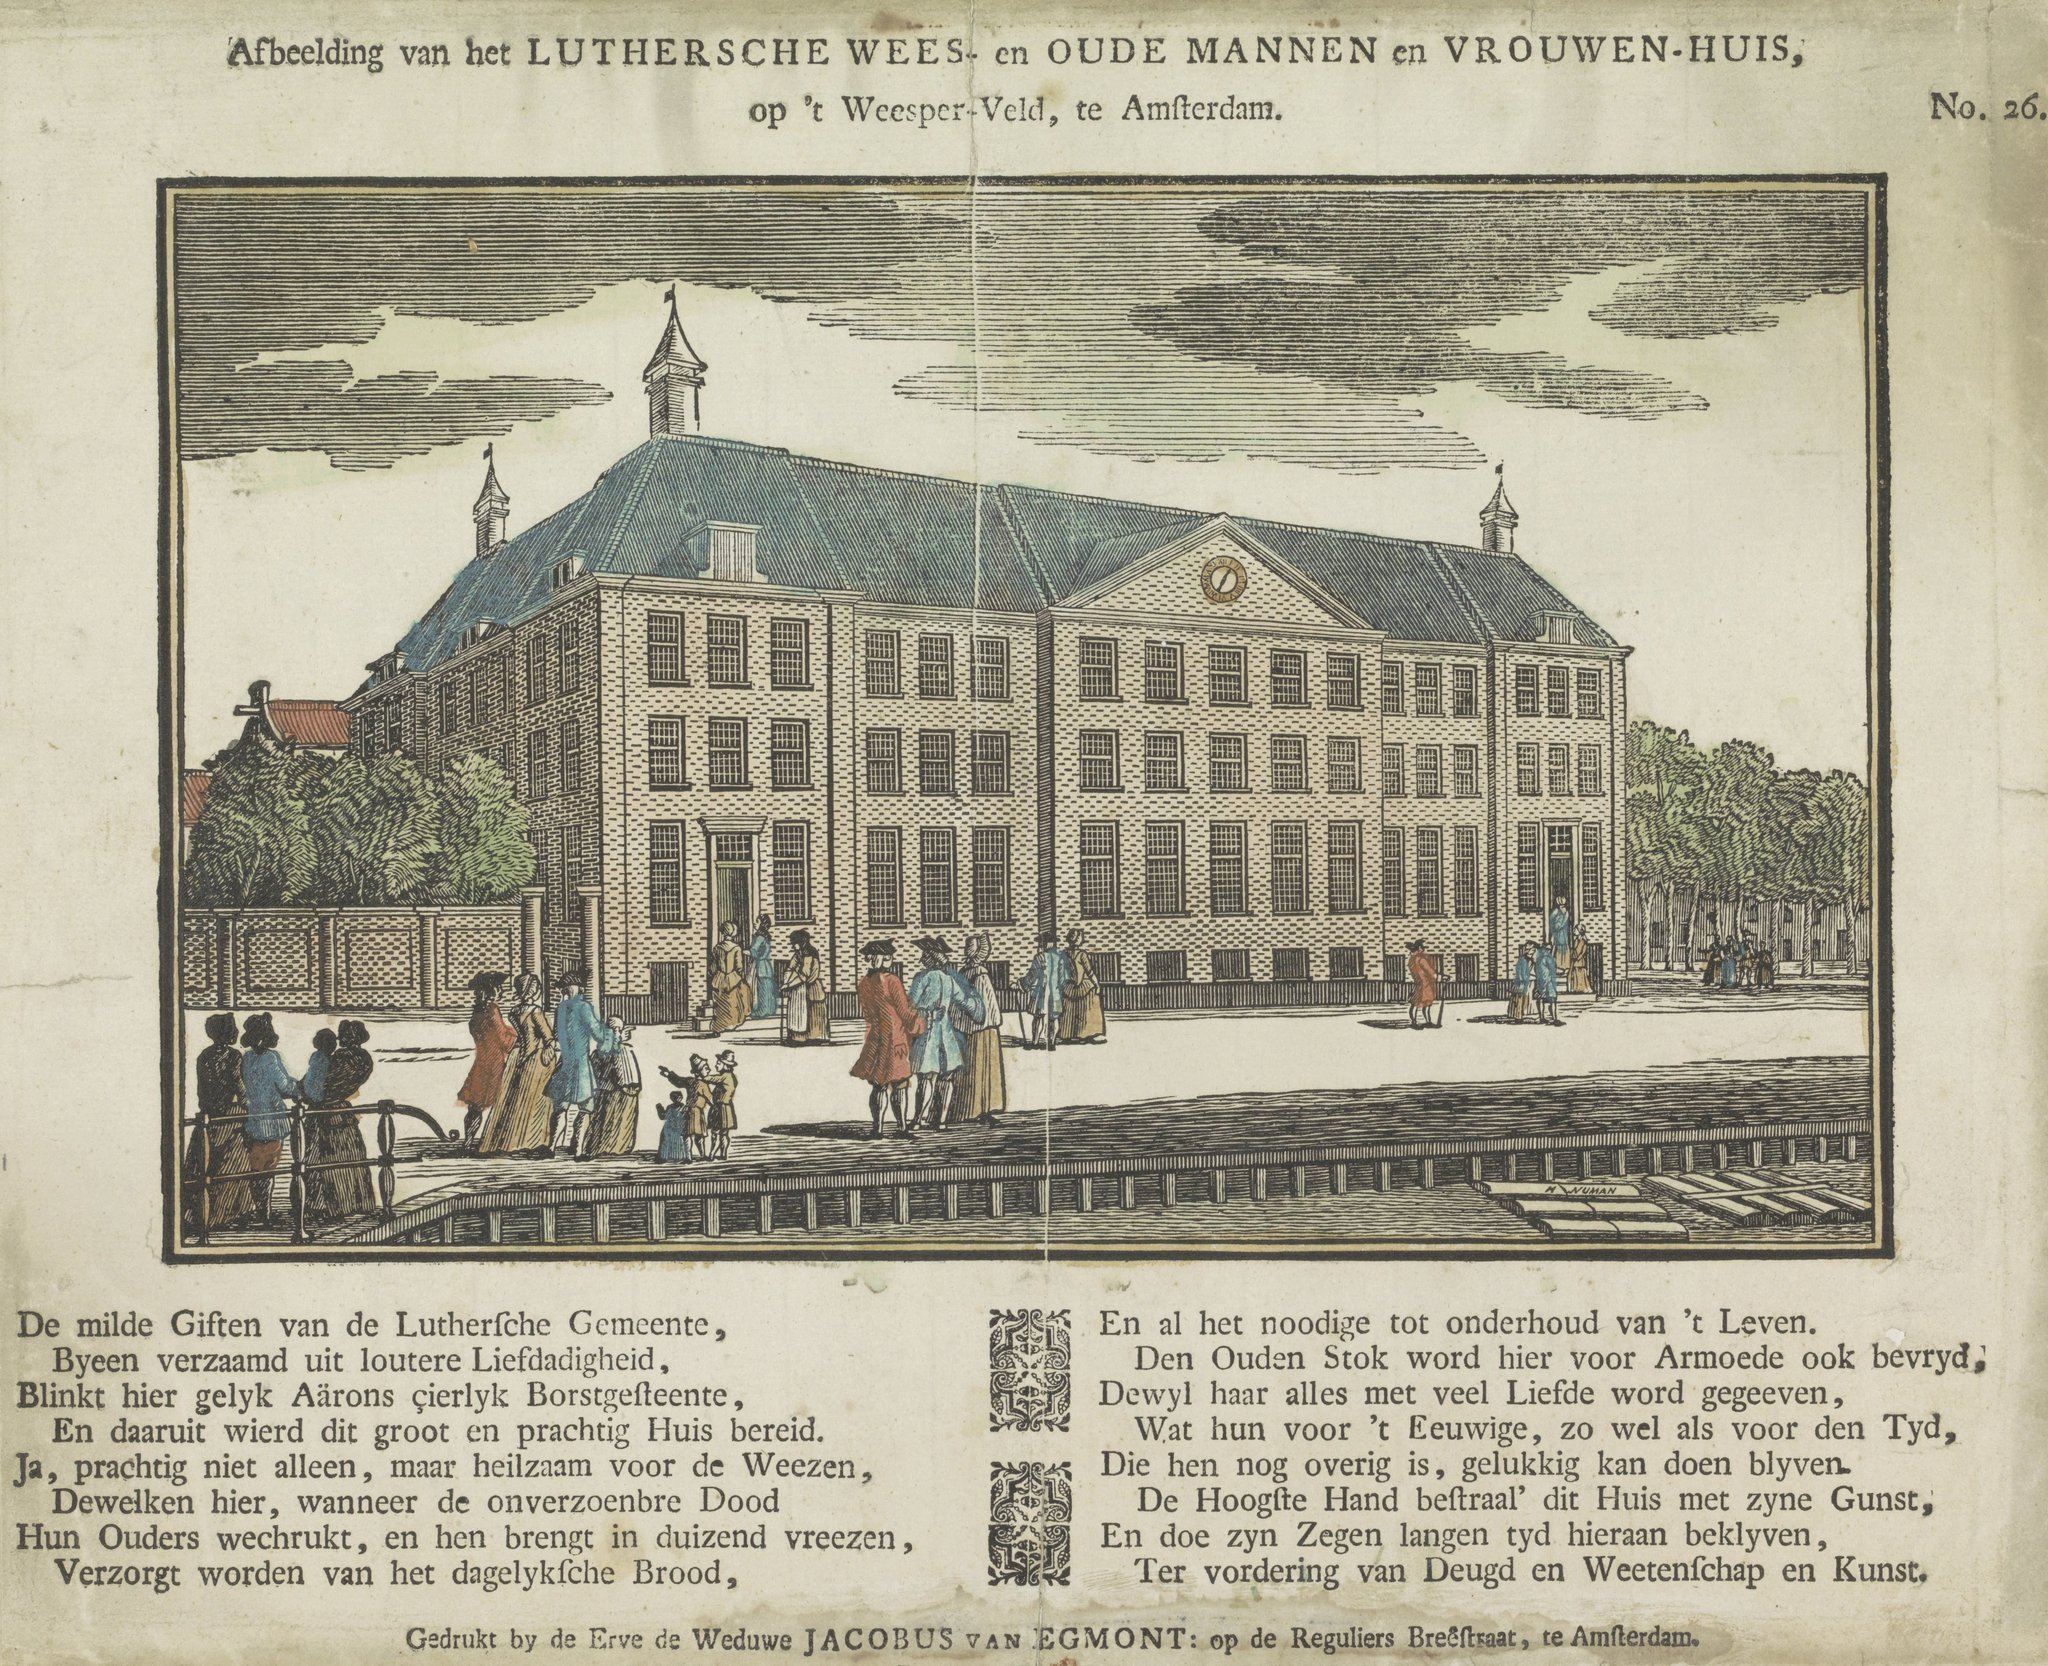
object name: print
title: Afbeelding van het Luthersche Wees- en Oude Mannen en Vrouwen-Huis, op 't Weesper-Veld, te Amsterdam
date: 1761-1804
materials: paper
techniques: colour, letterpress printing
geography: amsterdam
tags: orphanage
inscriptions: collector's mark: Lugt 2760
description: Blad met grote voorstelling van het Lutherse Diaconiehuis op 't Weesperveld te Amsterdam. Onder de voorstelling een vers in twee kolommen. Genummerd rechtsboven: No. 26.